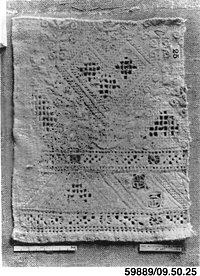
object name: fragment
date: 1601-1700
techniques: embroidery